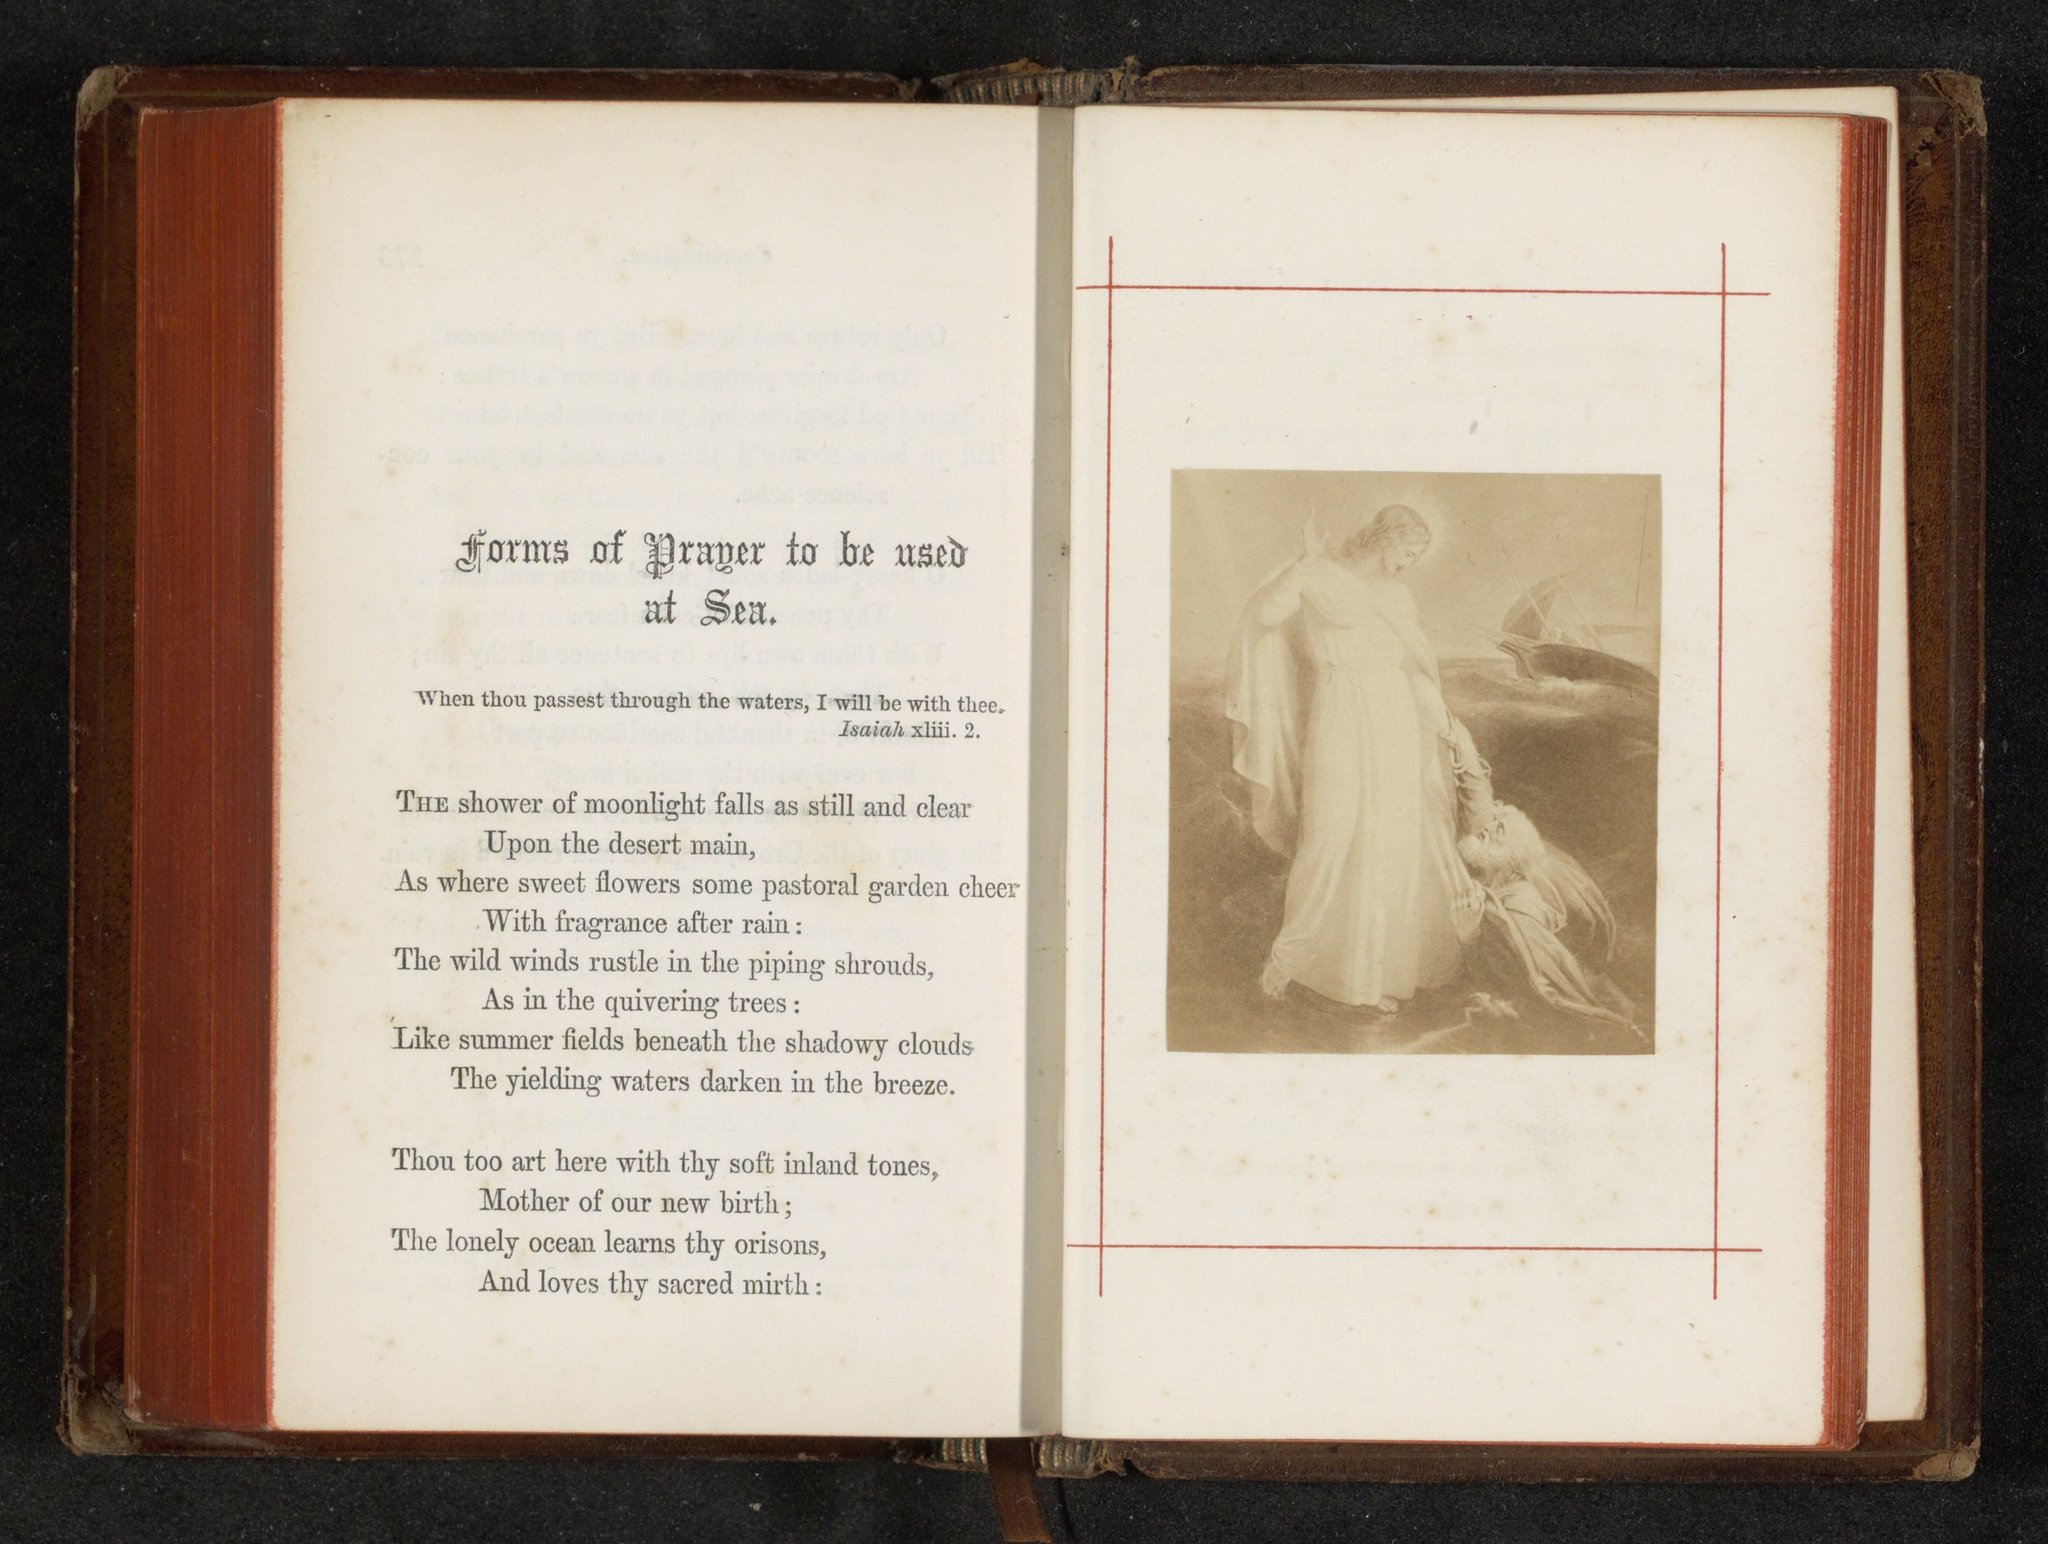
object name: reproduction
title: Fotoreproductie van een prent, voorstellende Christus redt Petrus van een verdrinkingsdood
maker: Anonymous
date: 1865-1870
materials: photographic support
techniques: albumen print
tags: christ saves peter from drowning